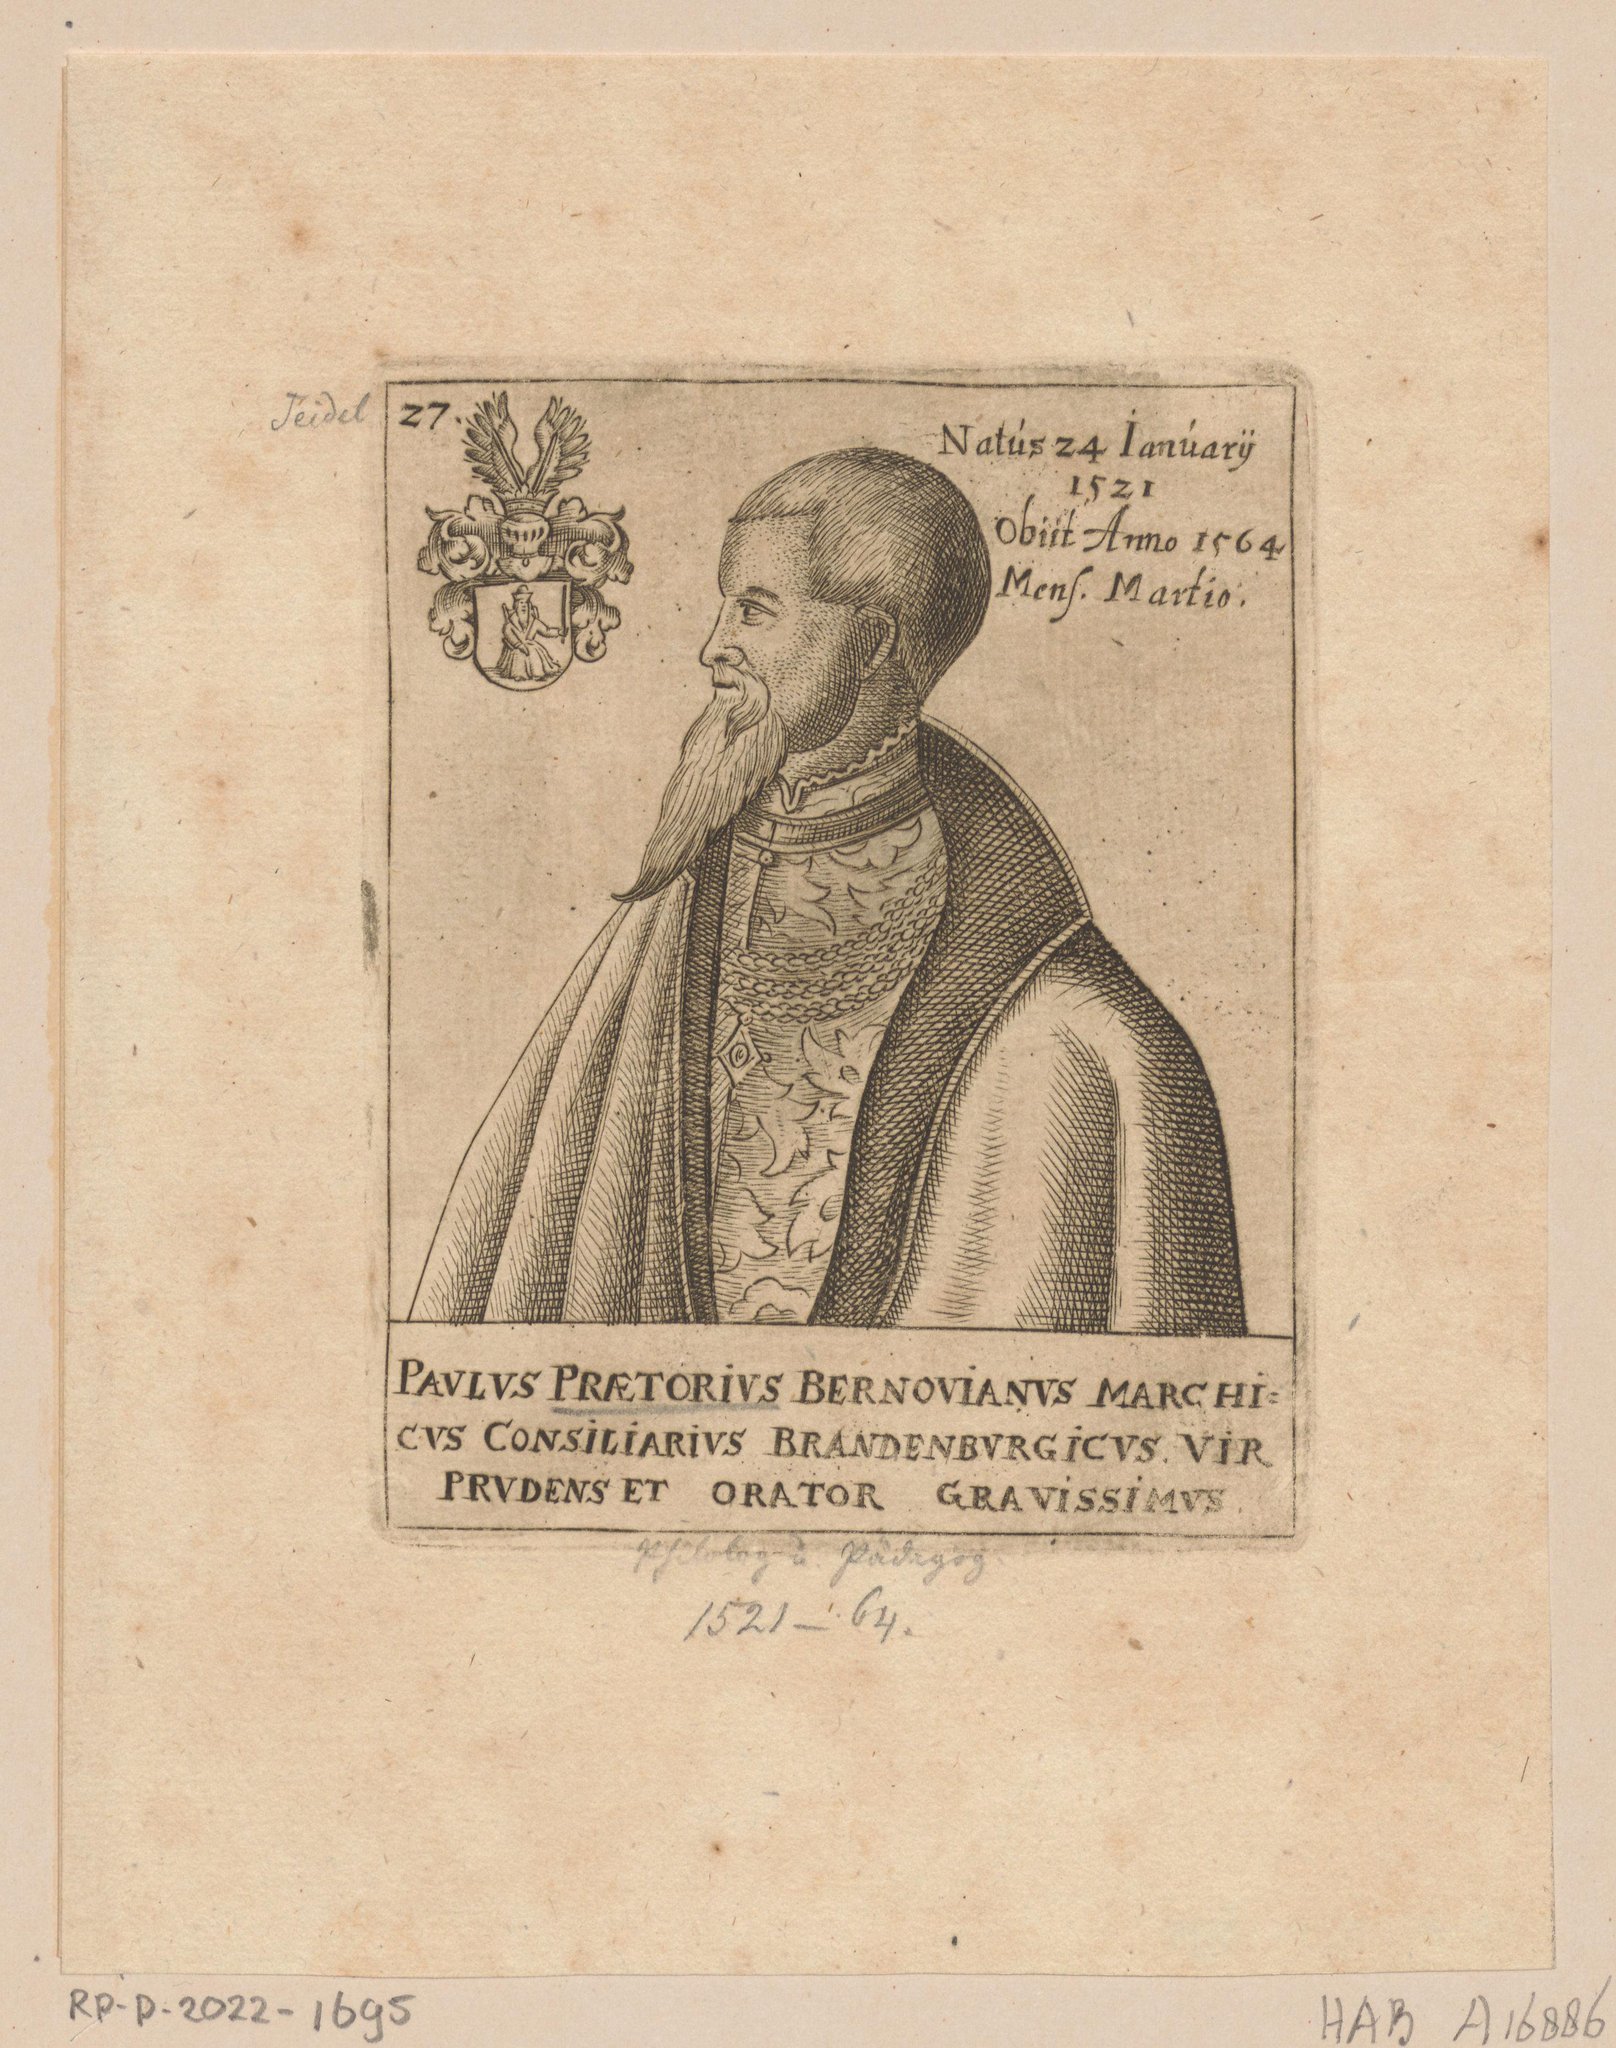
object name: print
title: Illustere mannen verzameld door Martin Friedrich Seidel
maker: Anonymous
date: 1751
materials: paper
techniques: engraving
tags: historical persons, armorial bearing, heraldry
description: De prent is uitgegeven als onderdeel van een serie. Later is de prent mogelijk ook als boekillustratie gebruikt in: Küster, Georg Gottfried. Martin Friedrich Seidels Bilder-Sammlung in welcher hundert, gröstentheils in der Mark Brandenburg (…). Berlijn: Buchladen bey der Real-Schule, 1751. Het is onduidelijk tot welke uitgave de huidige prent behoort.